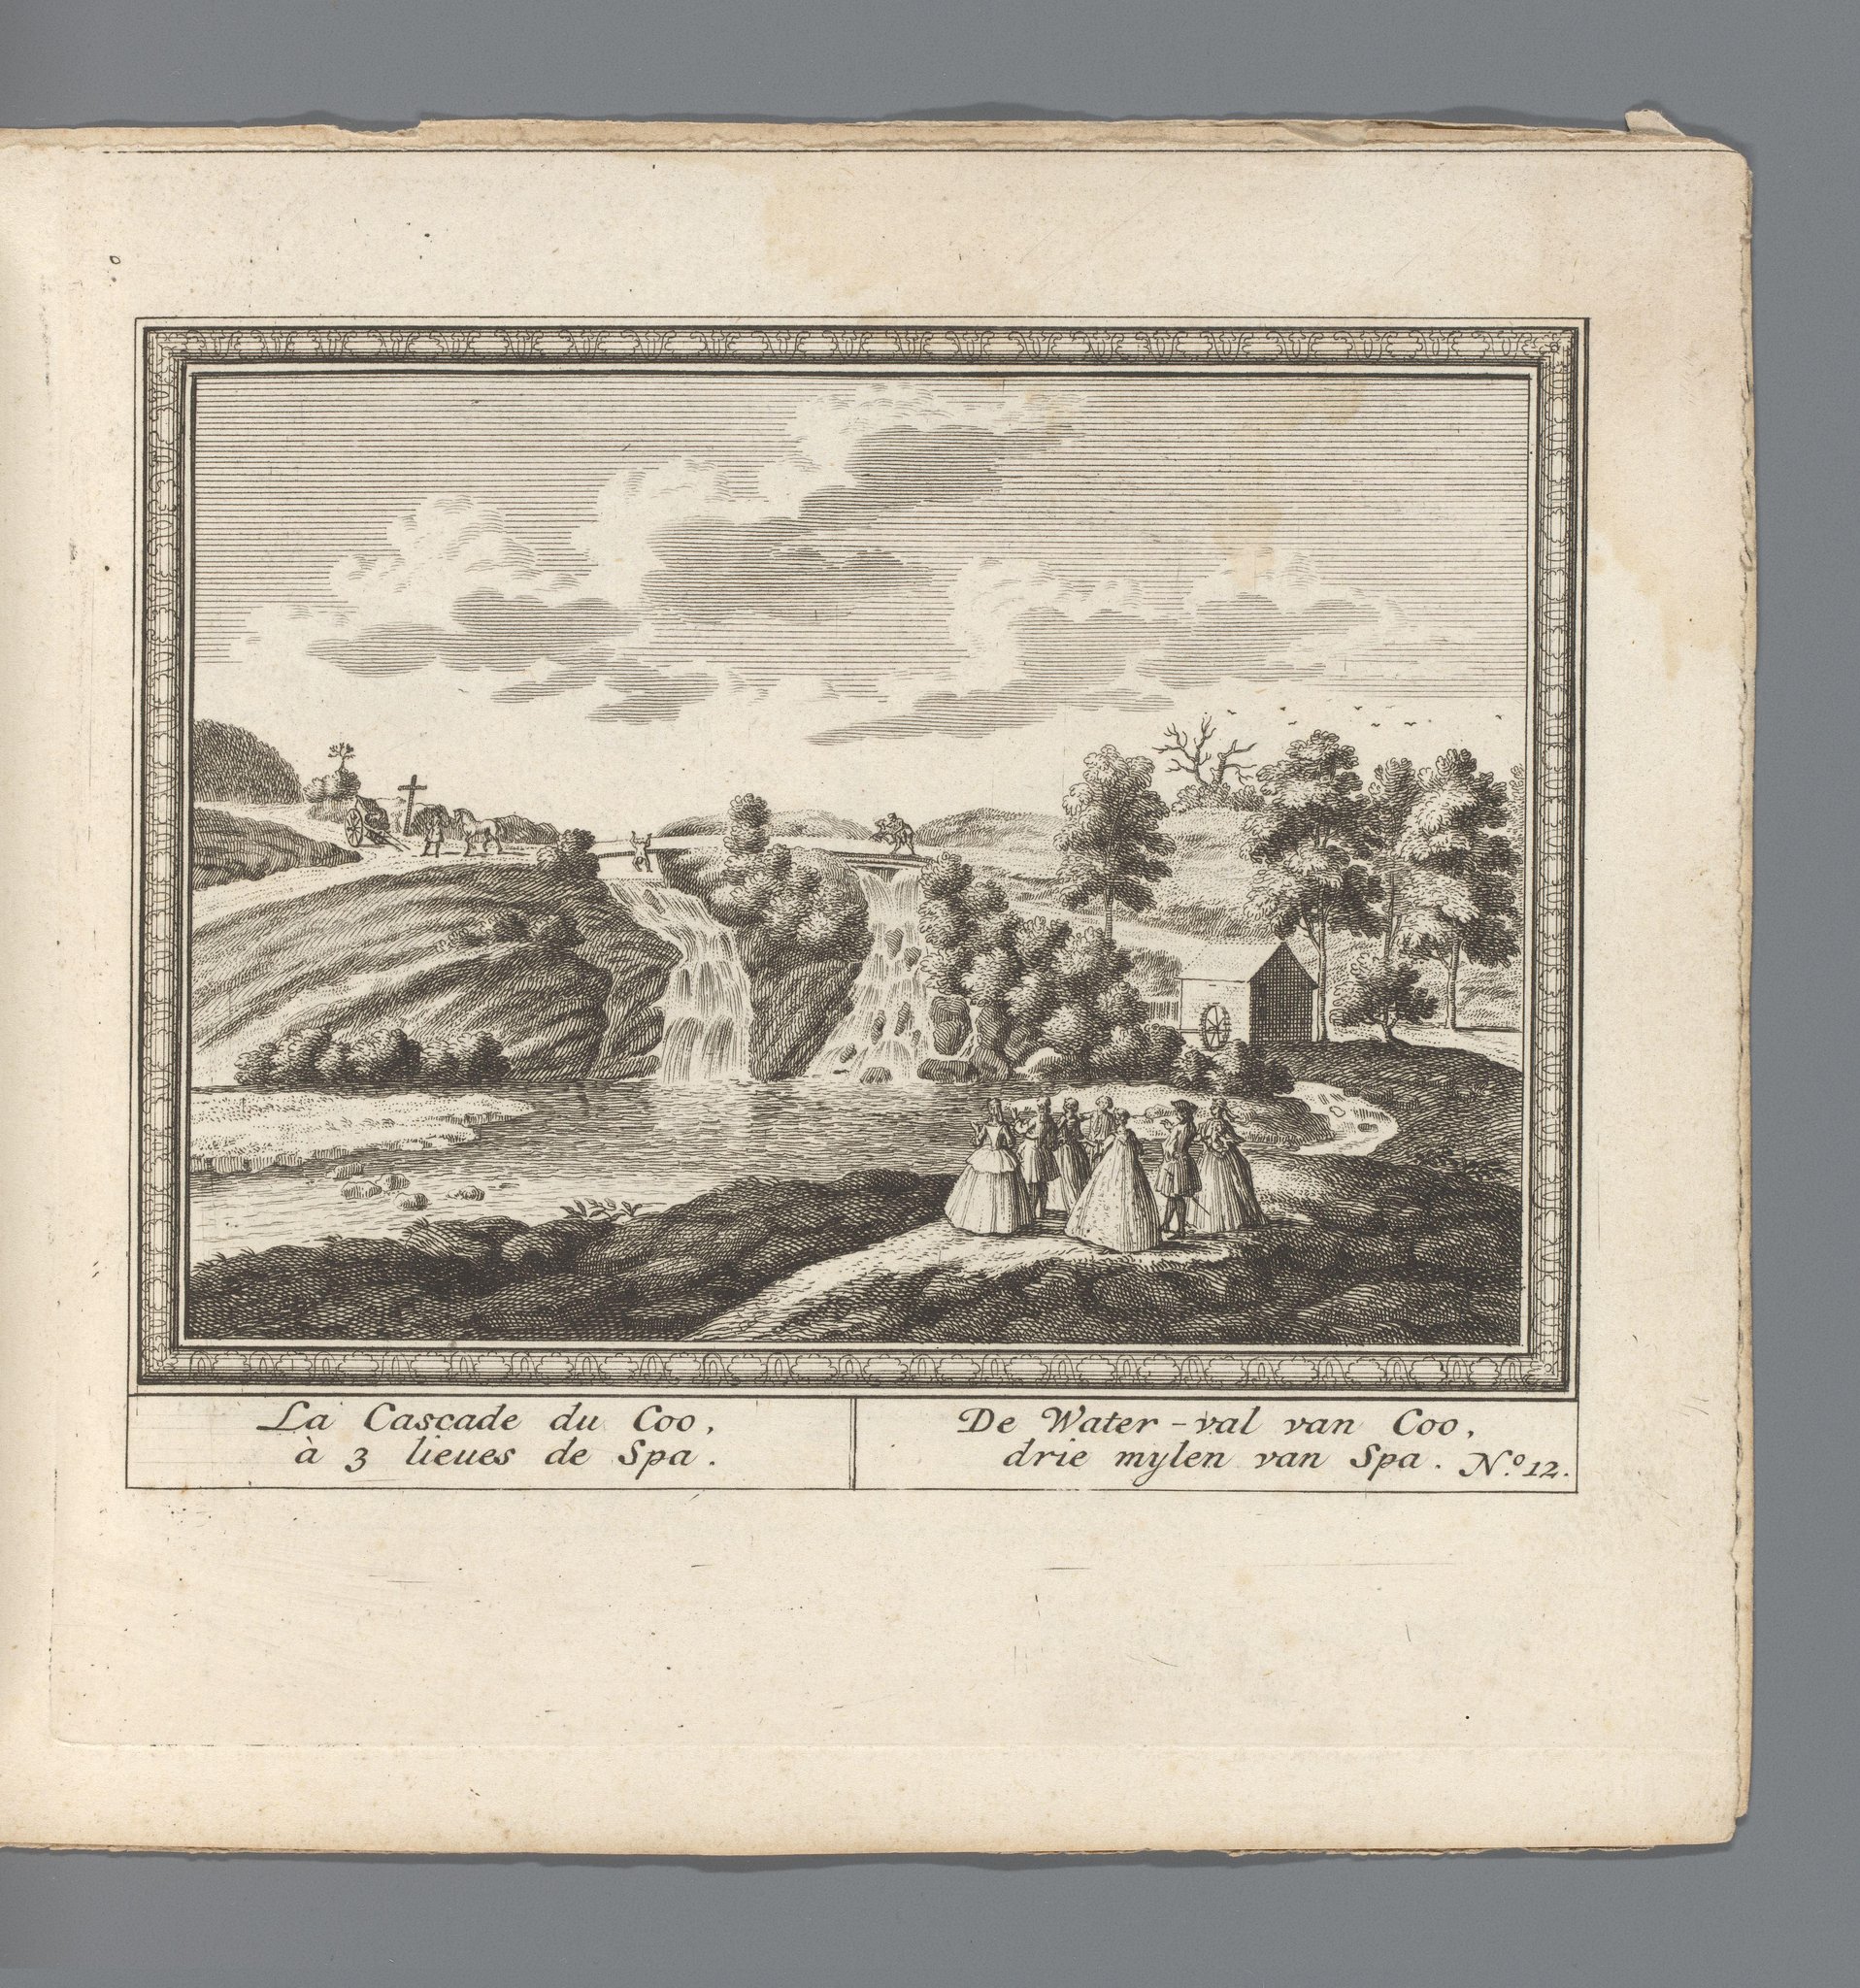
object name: book illustration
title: Gezichten van de bronnen bij Spa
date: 1734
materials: paper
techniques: etching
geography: amsterdam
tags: city-view in general; 'veduta', mineral water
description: Deze serie prenten is gebruikt in: Pöllnitz, Charles-Louis. Amuseums des eaux de Spa. Ouvrage utile a ceux qui vont boire ces eaux minérales sur les lieux. 2 dln. Amsterdam: Pieter Mortier, 1734. In deze uitgave zijn de prenten echter gevouwen. Mogelijk is deze serie een losse uitgave van de prenten. Er ontbreekt één prent die in het boek is opgenomen (nr. 4), waarop geen landschap is afgebeeld.